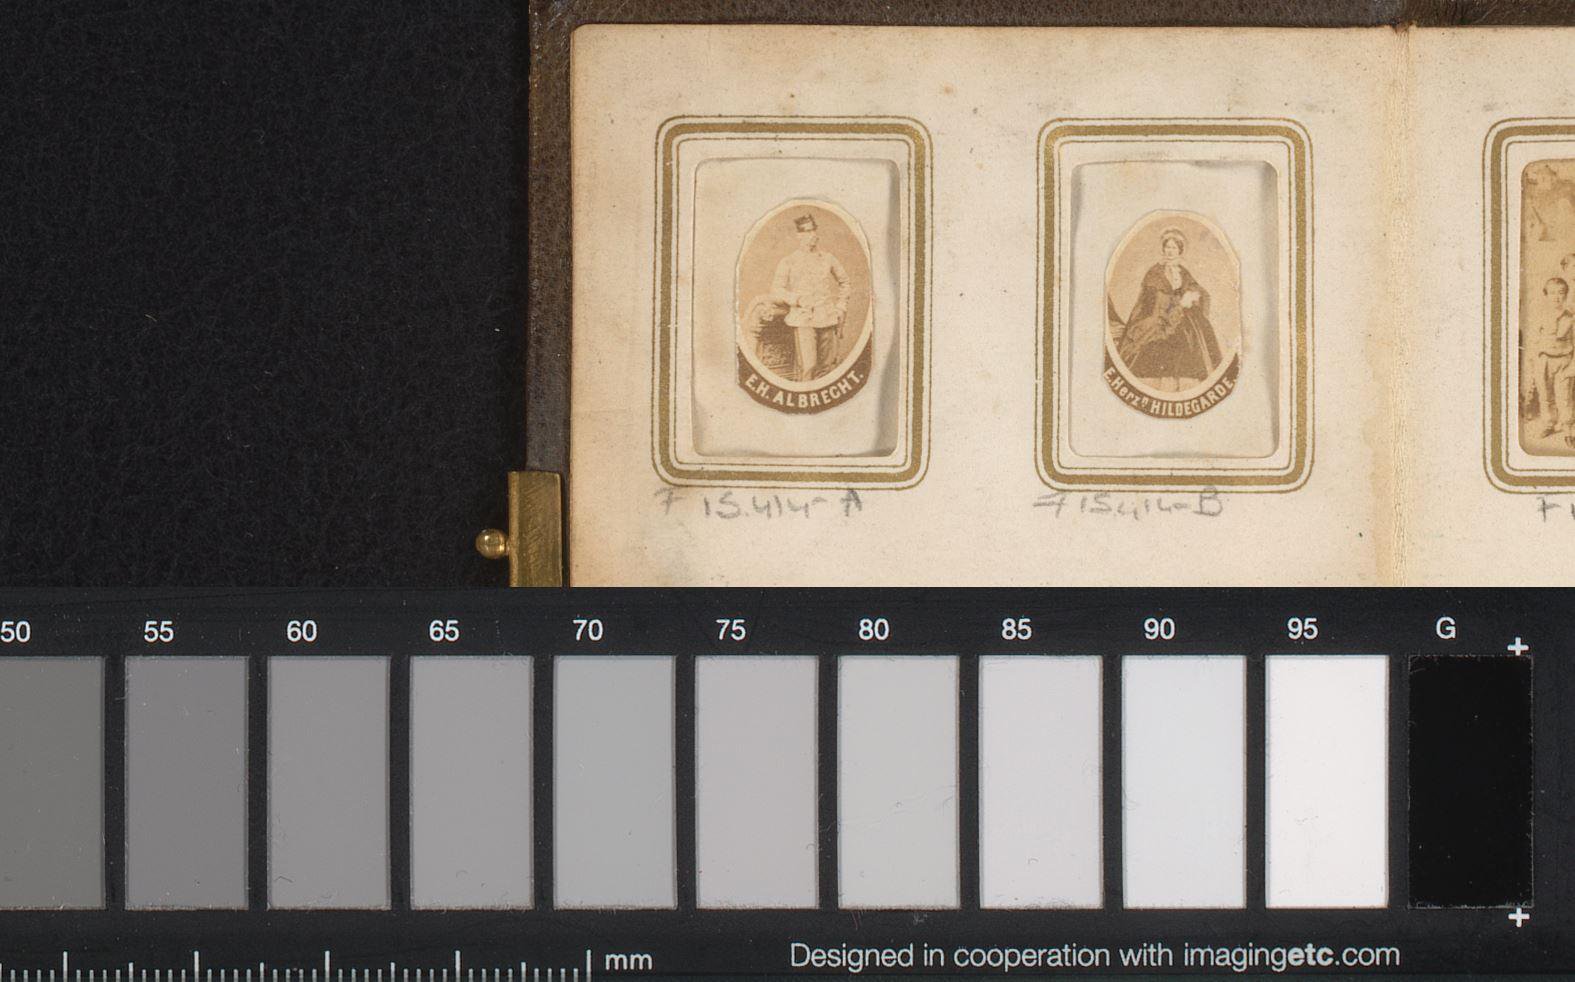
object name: photograph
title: E.H. Albrecht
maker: Anonymous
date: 1851-1900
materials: paper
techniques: albumen print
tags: vienna, nobility and patriciate; chivalry, knighthood